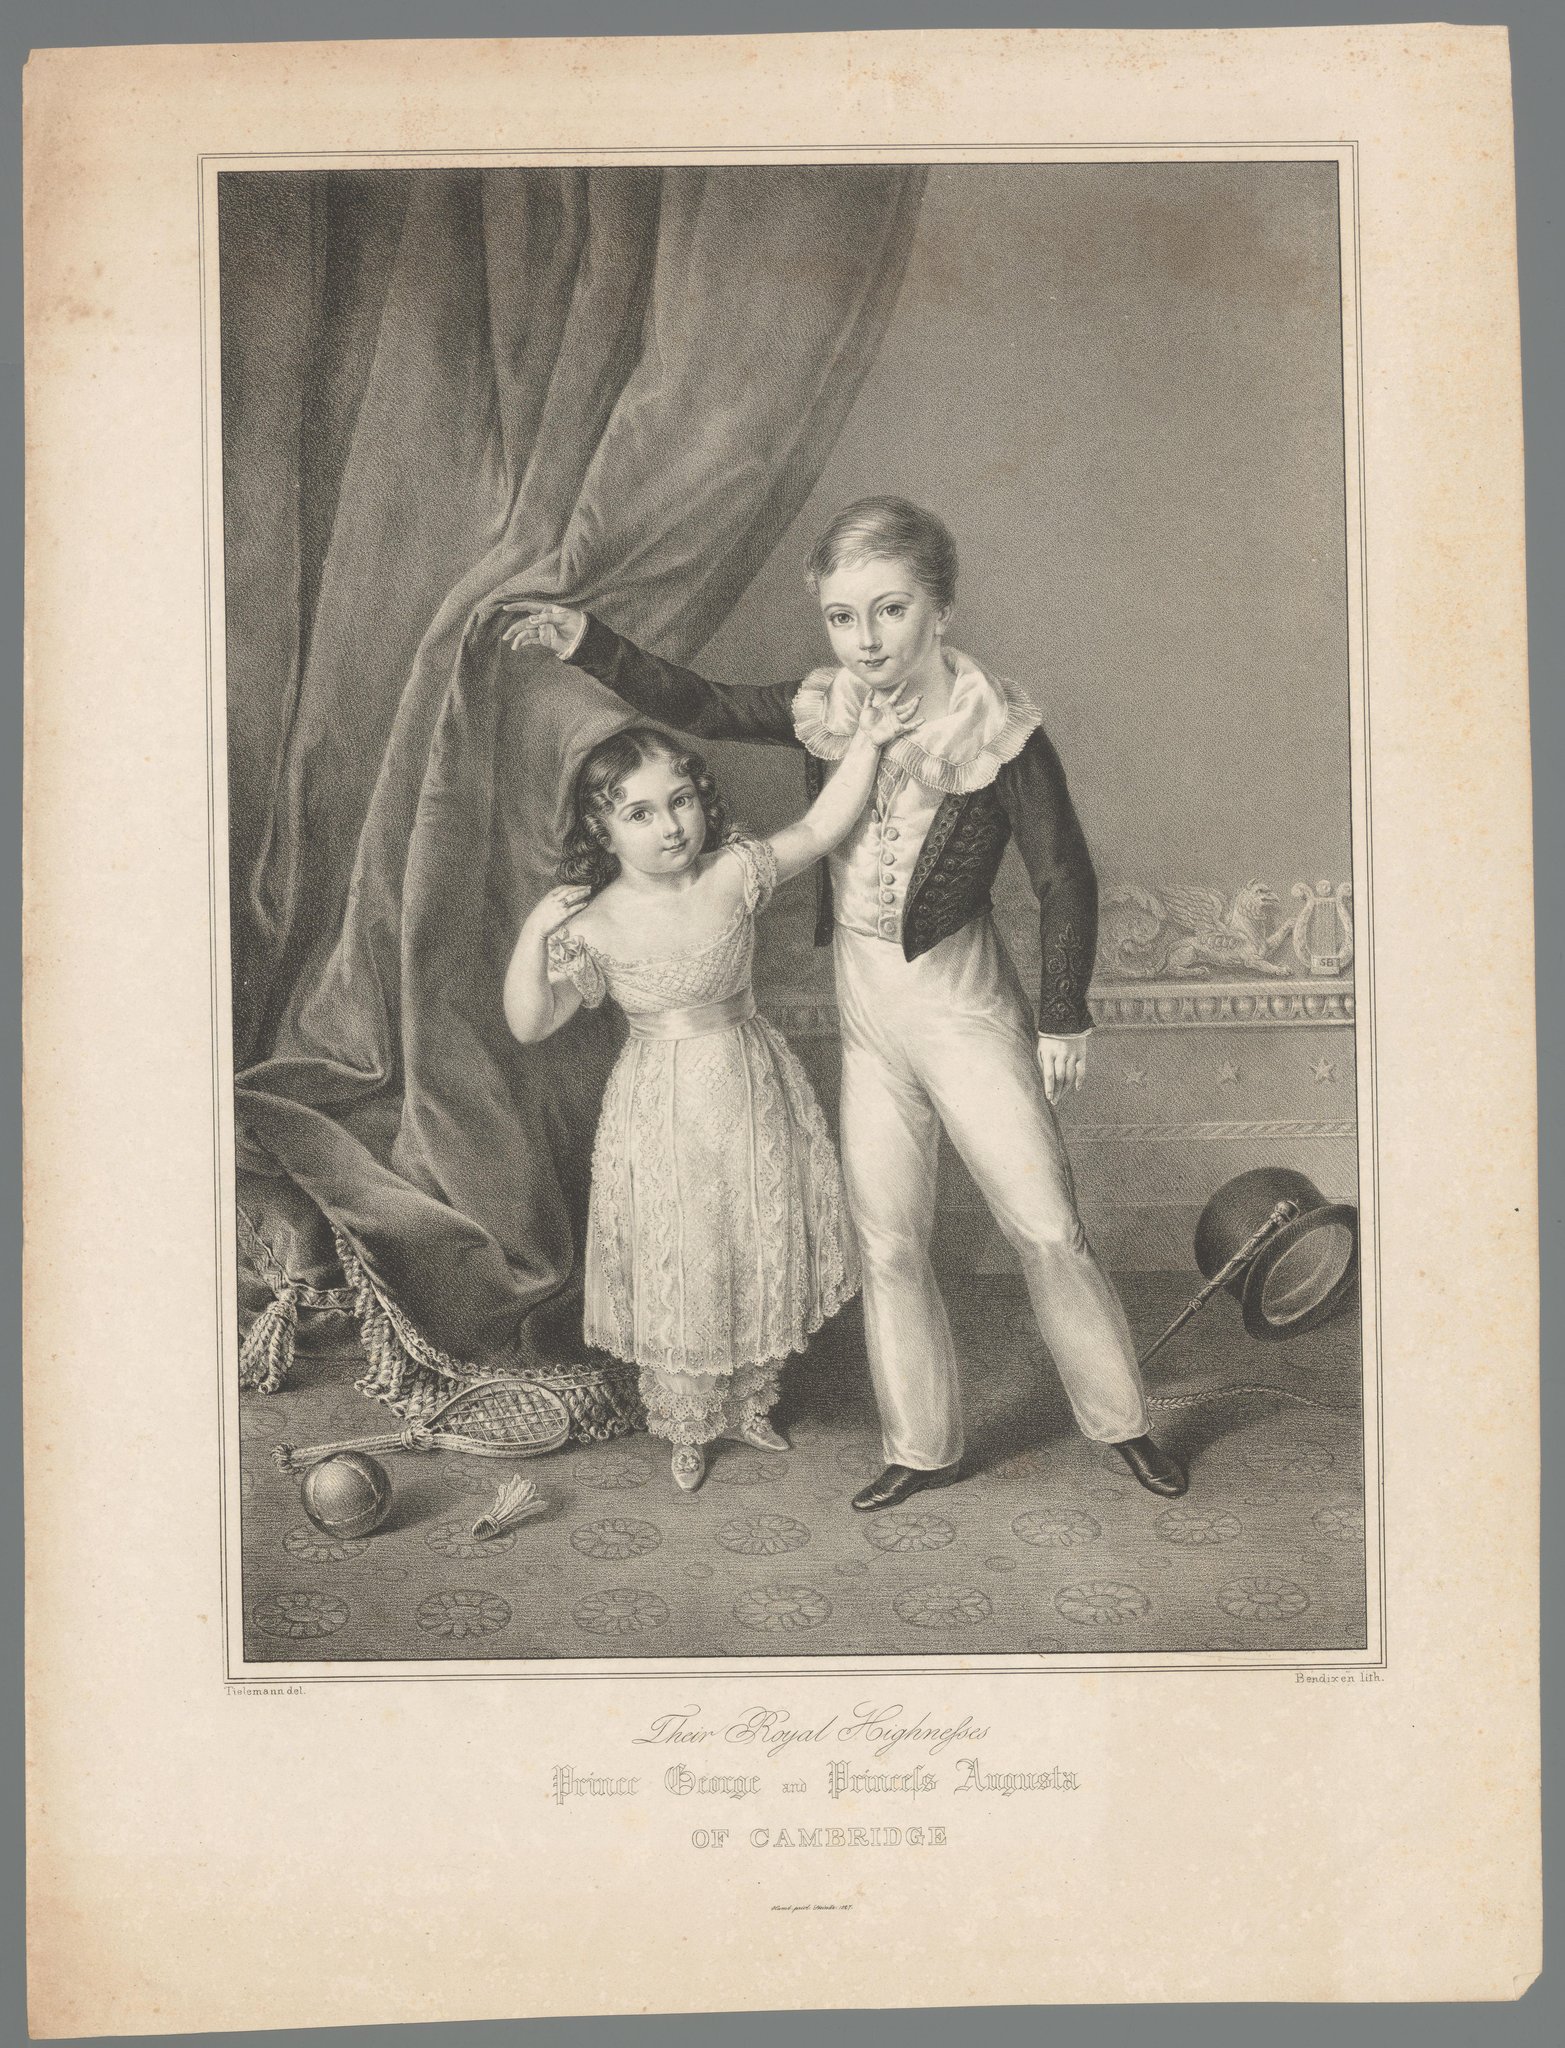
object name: print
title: Portret van George en Augusta van Cambridge als kinderen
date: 1827-1864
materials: paper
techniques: lithograph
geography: hamburg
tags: london, curtains, child, historical persons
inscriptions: collector's mark: Lugt 2228